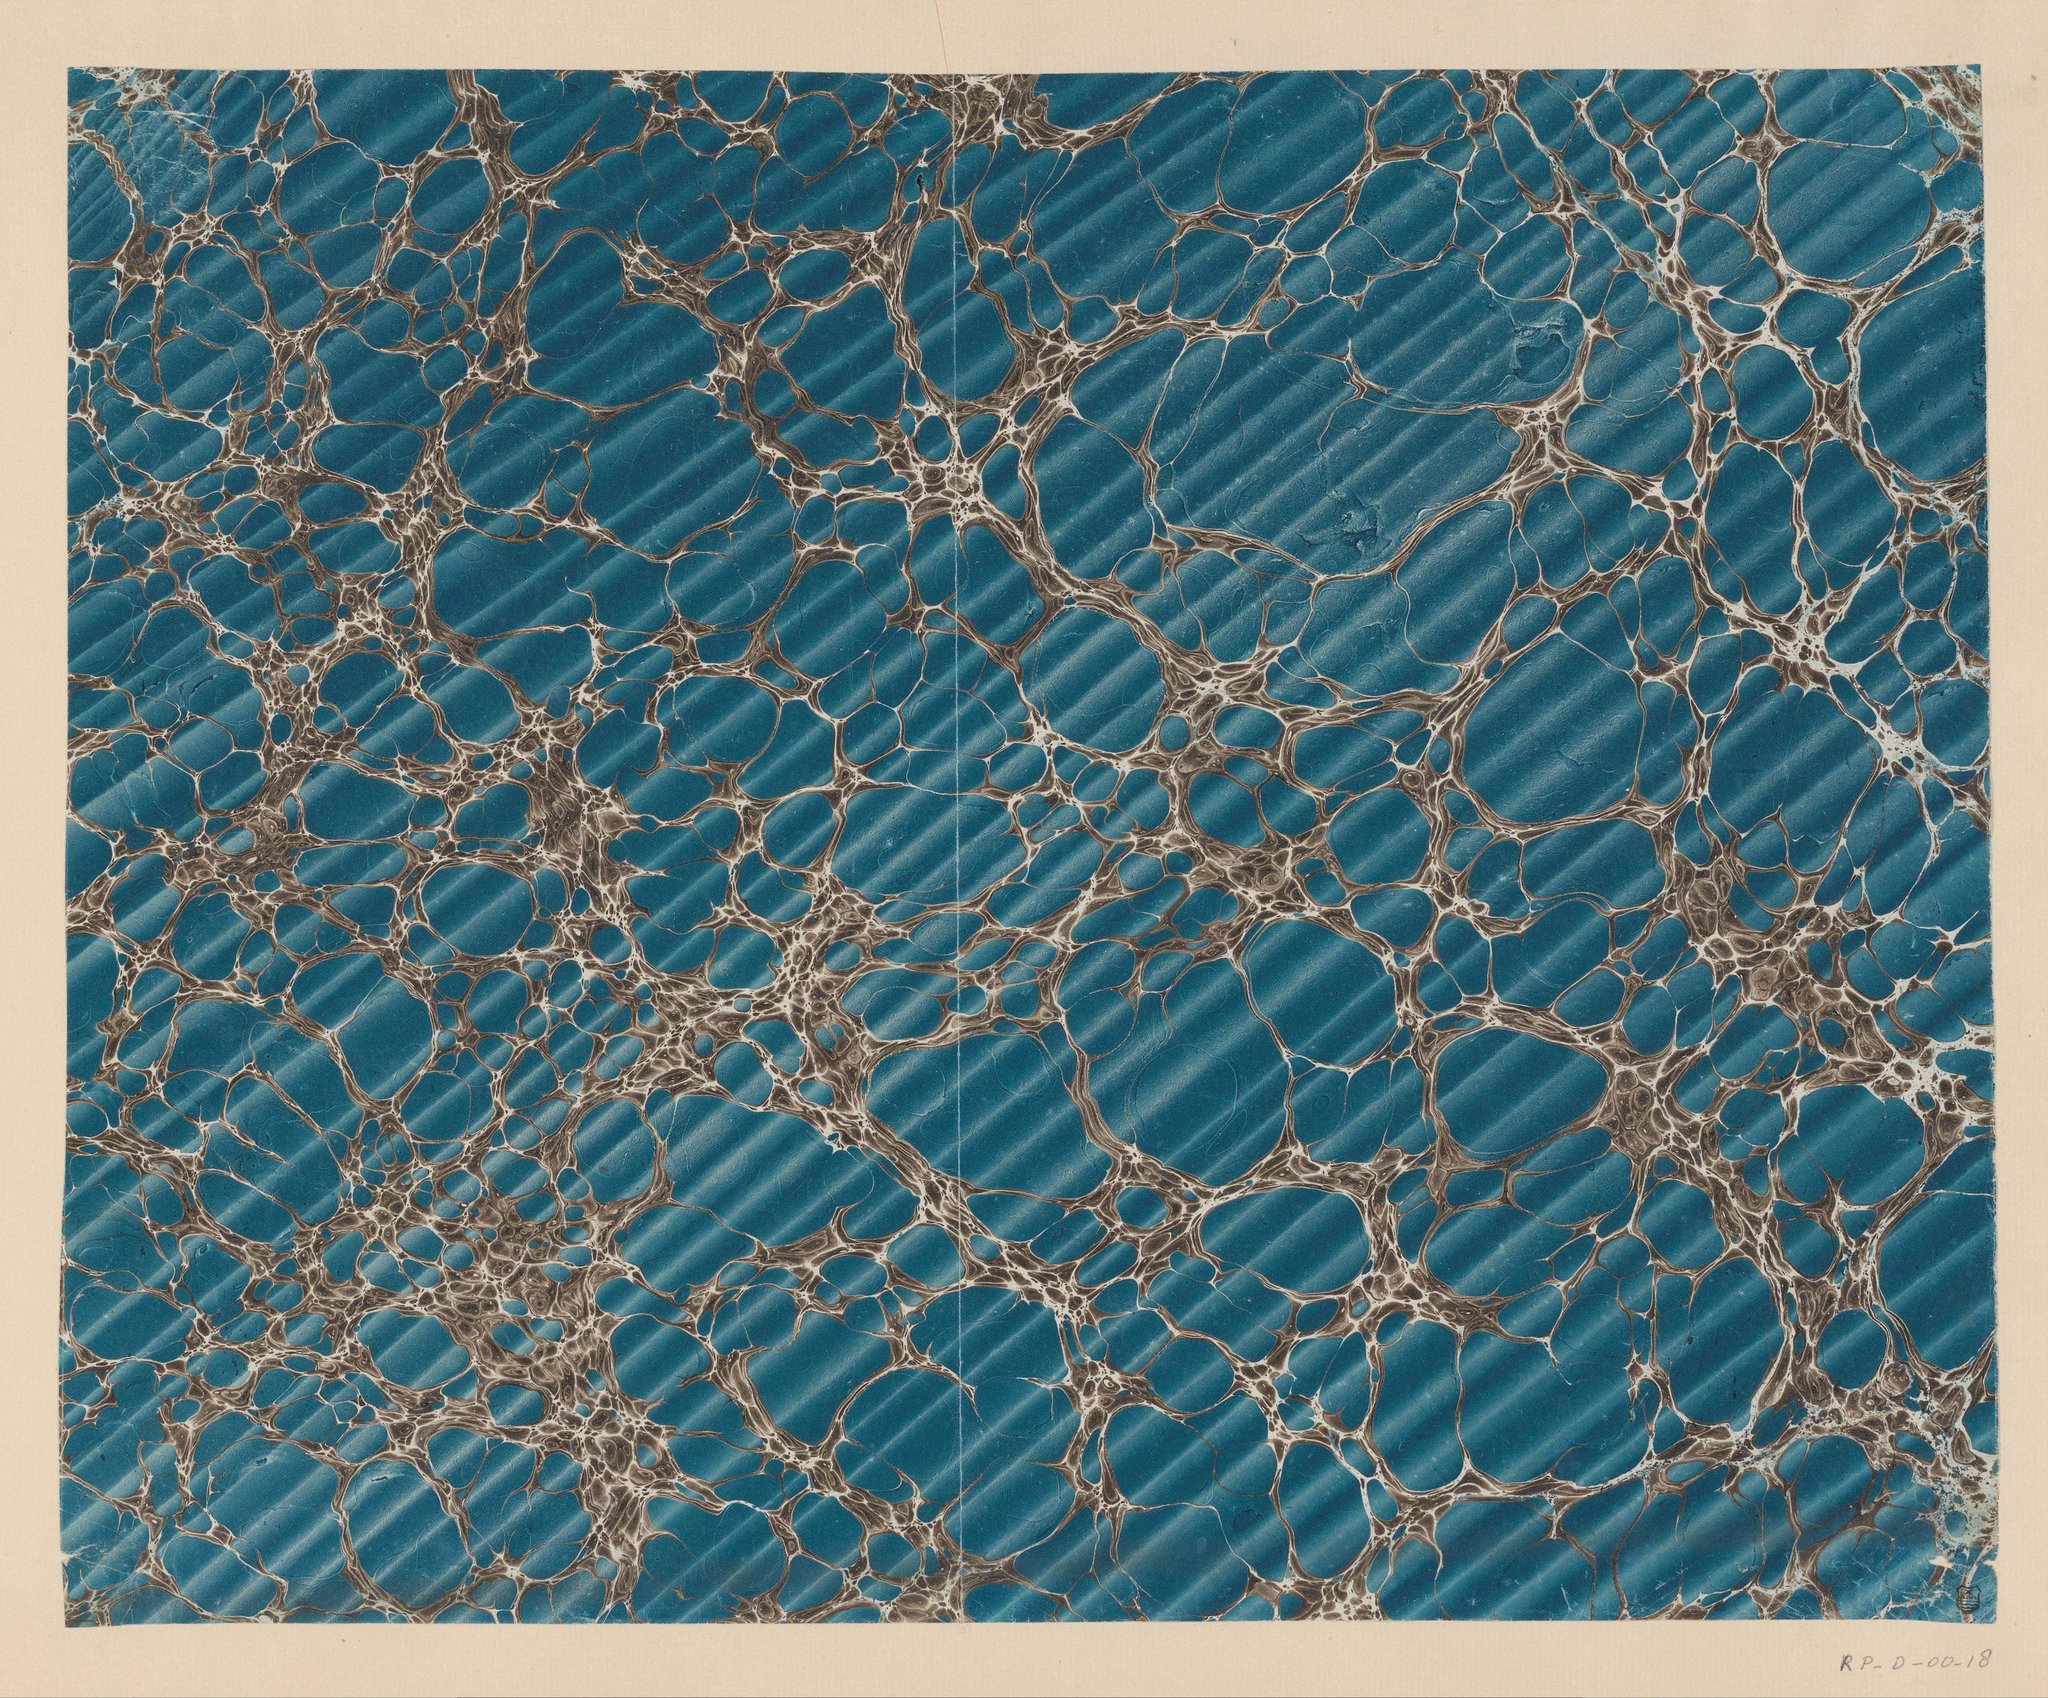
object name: marbled paper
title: Rechtschaduwmarmer in blauw en grijs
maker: Anonymous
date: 1850-1917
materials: paint, paper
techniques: marbled paper, marbling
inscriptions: collector's mark: Lugt 2760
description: Rechtschaduwmarmer op kiezelmarmer in blauw en grijs.